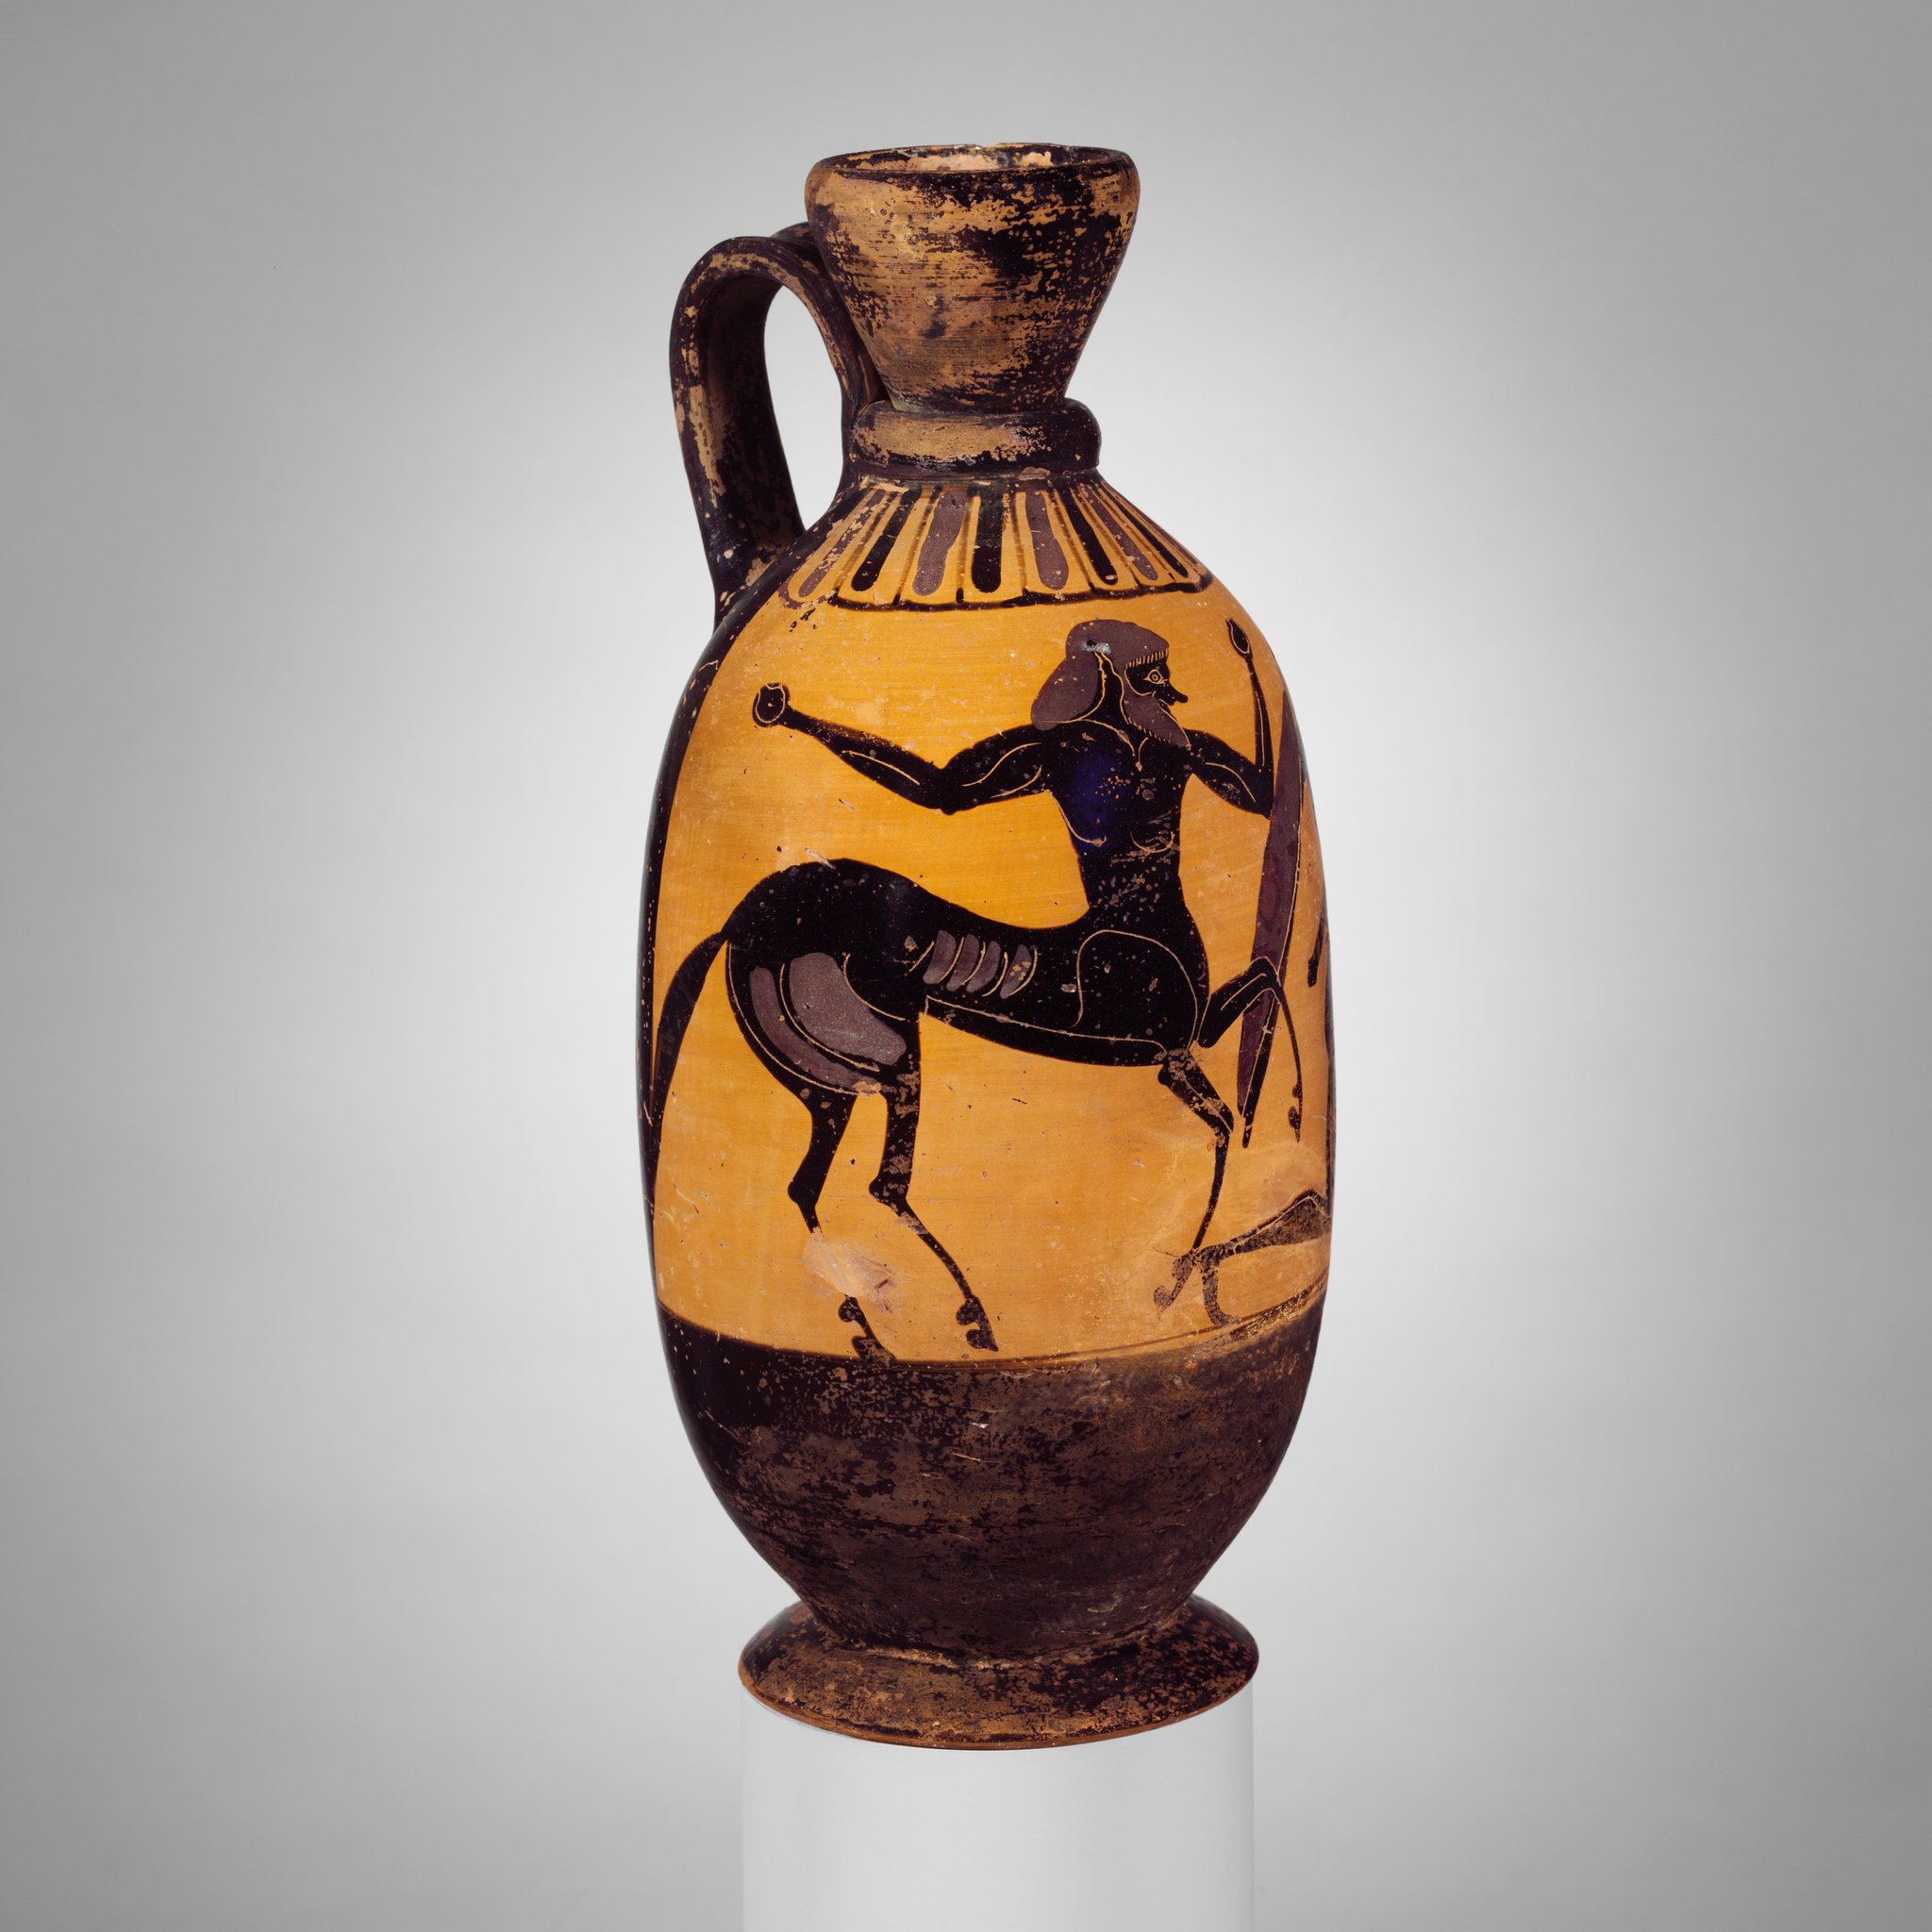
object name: lekythos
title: Terracotta lekythos (oil flask) with centaur battling a warrior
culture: greek, attic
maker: painter of london b 31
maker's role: artist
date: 575-550 BCE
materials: terracotta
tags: centaurs,warriors